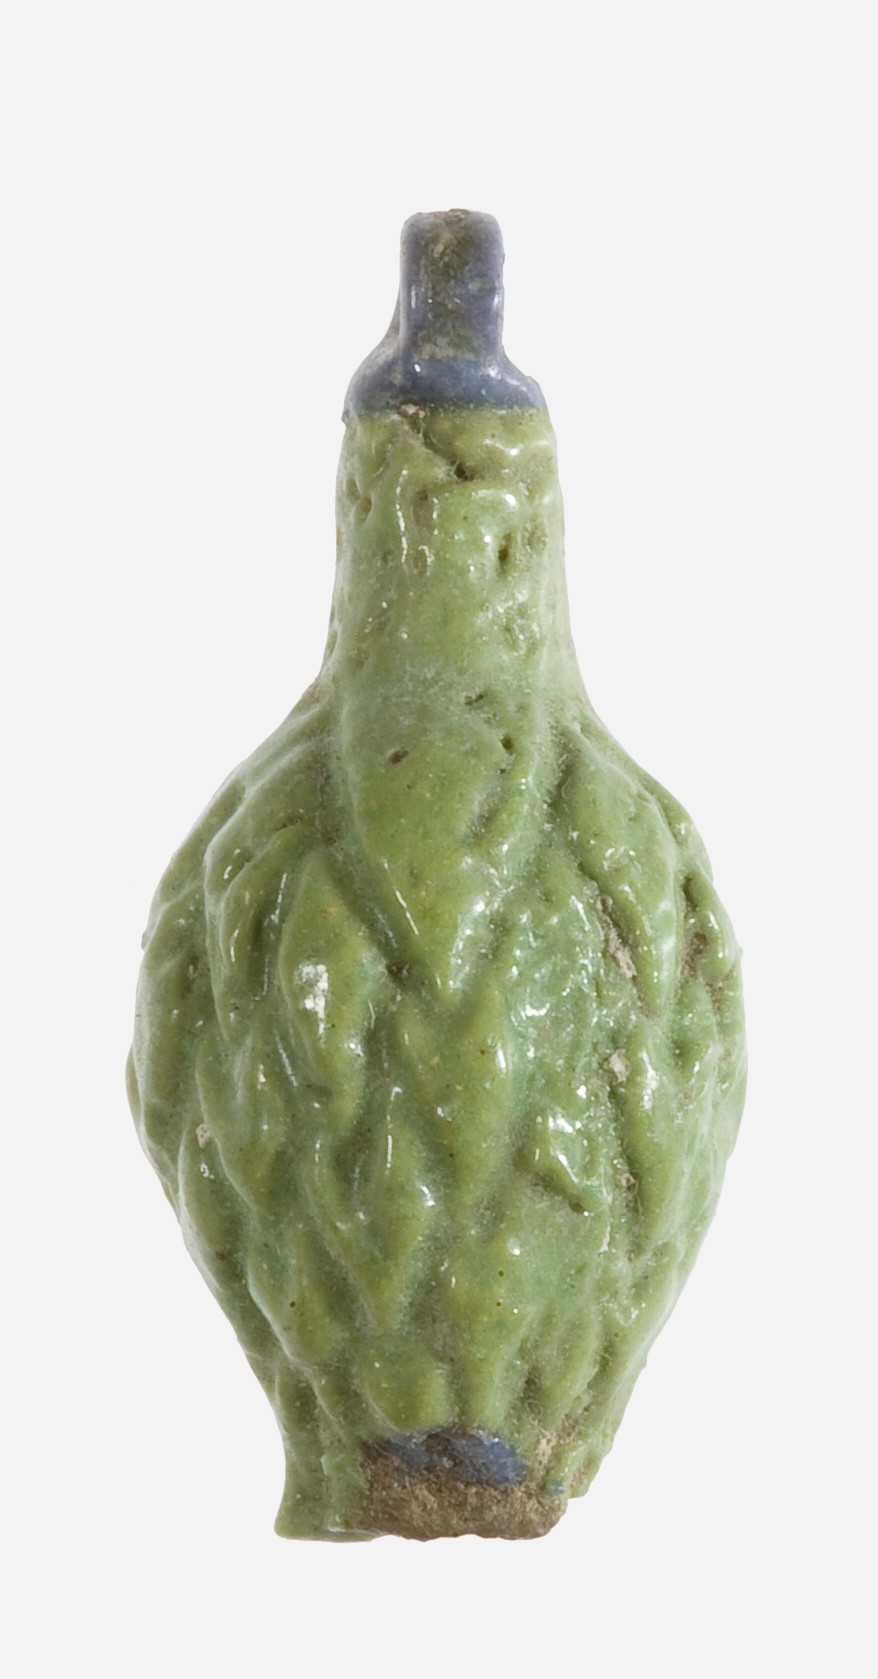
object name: pendant, cornflower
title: Cornflower Pendant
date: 1390-1352 BCE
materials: faience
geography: egypt